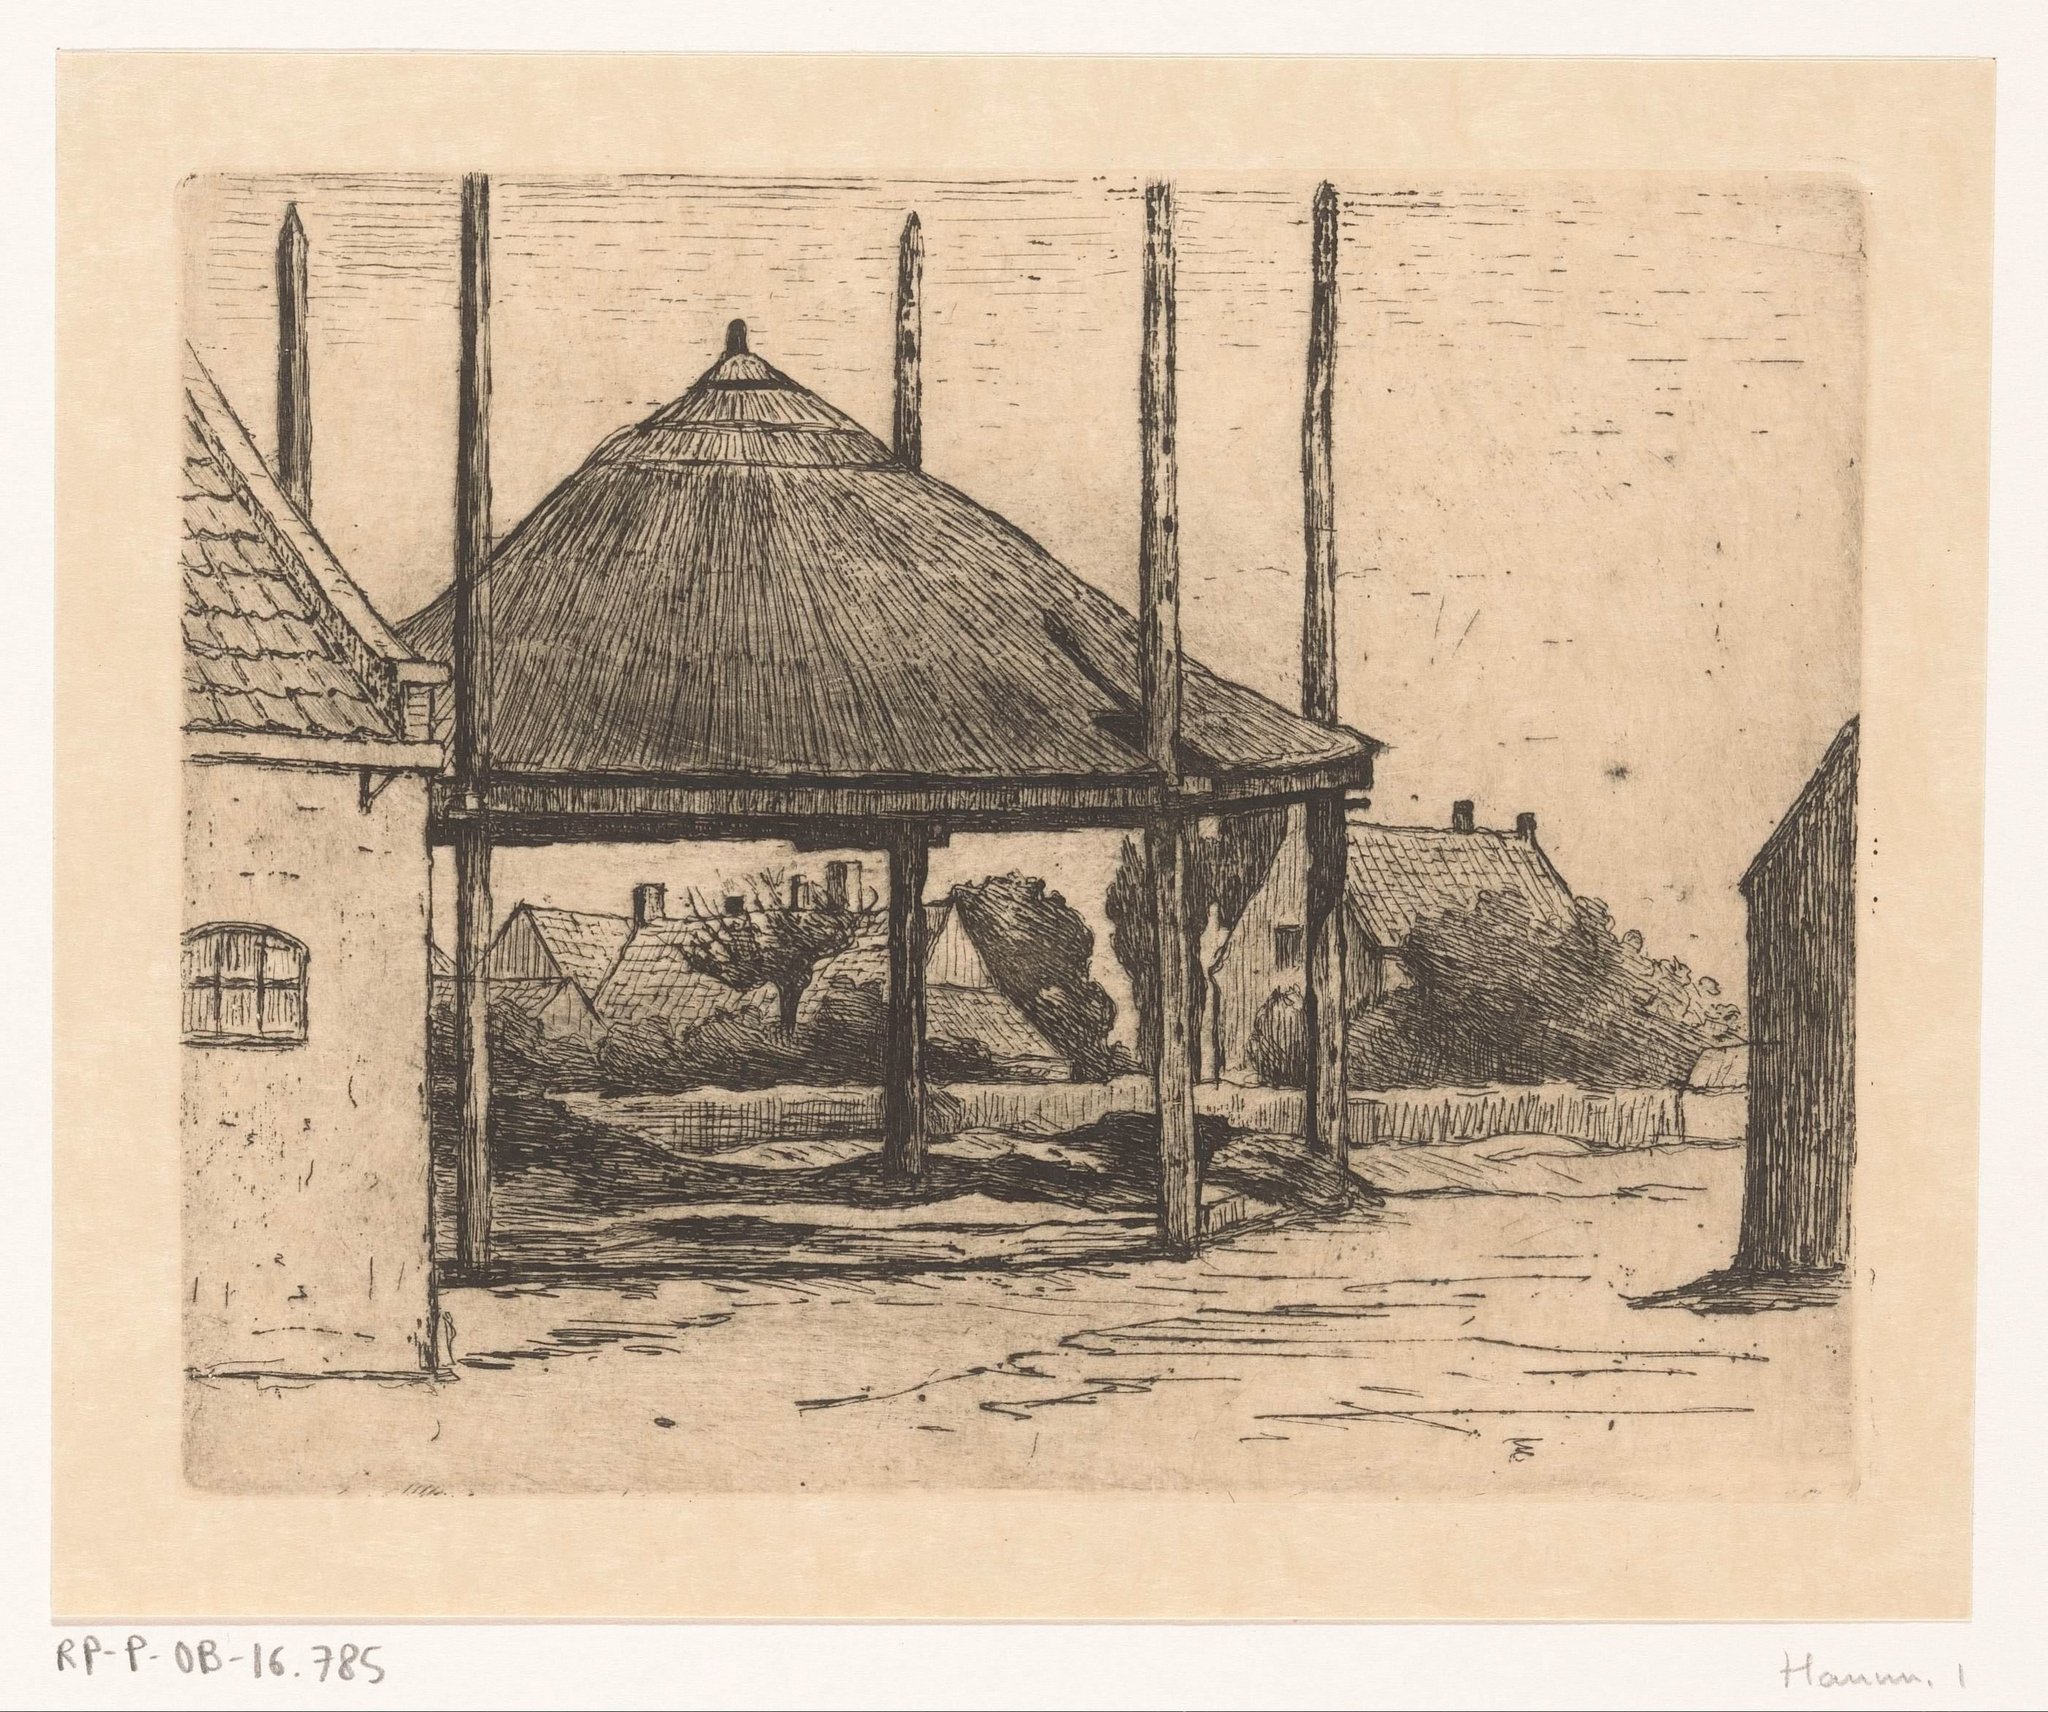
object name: print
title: Boerenerf met lege hooischuur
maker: eduard karsen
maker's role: draughtsman, painter, print maker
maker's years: 1860-1941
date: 1895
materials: paper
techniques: etching, intaglio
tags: barn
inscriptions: collector's mark: Lugt 2228